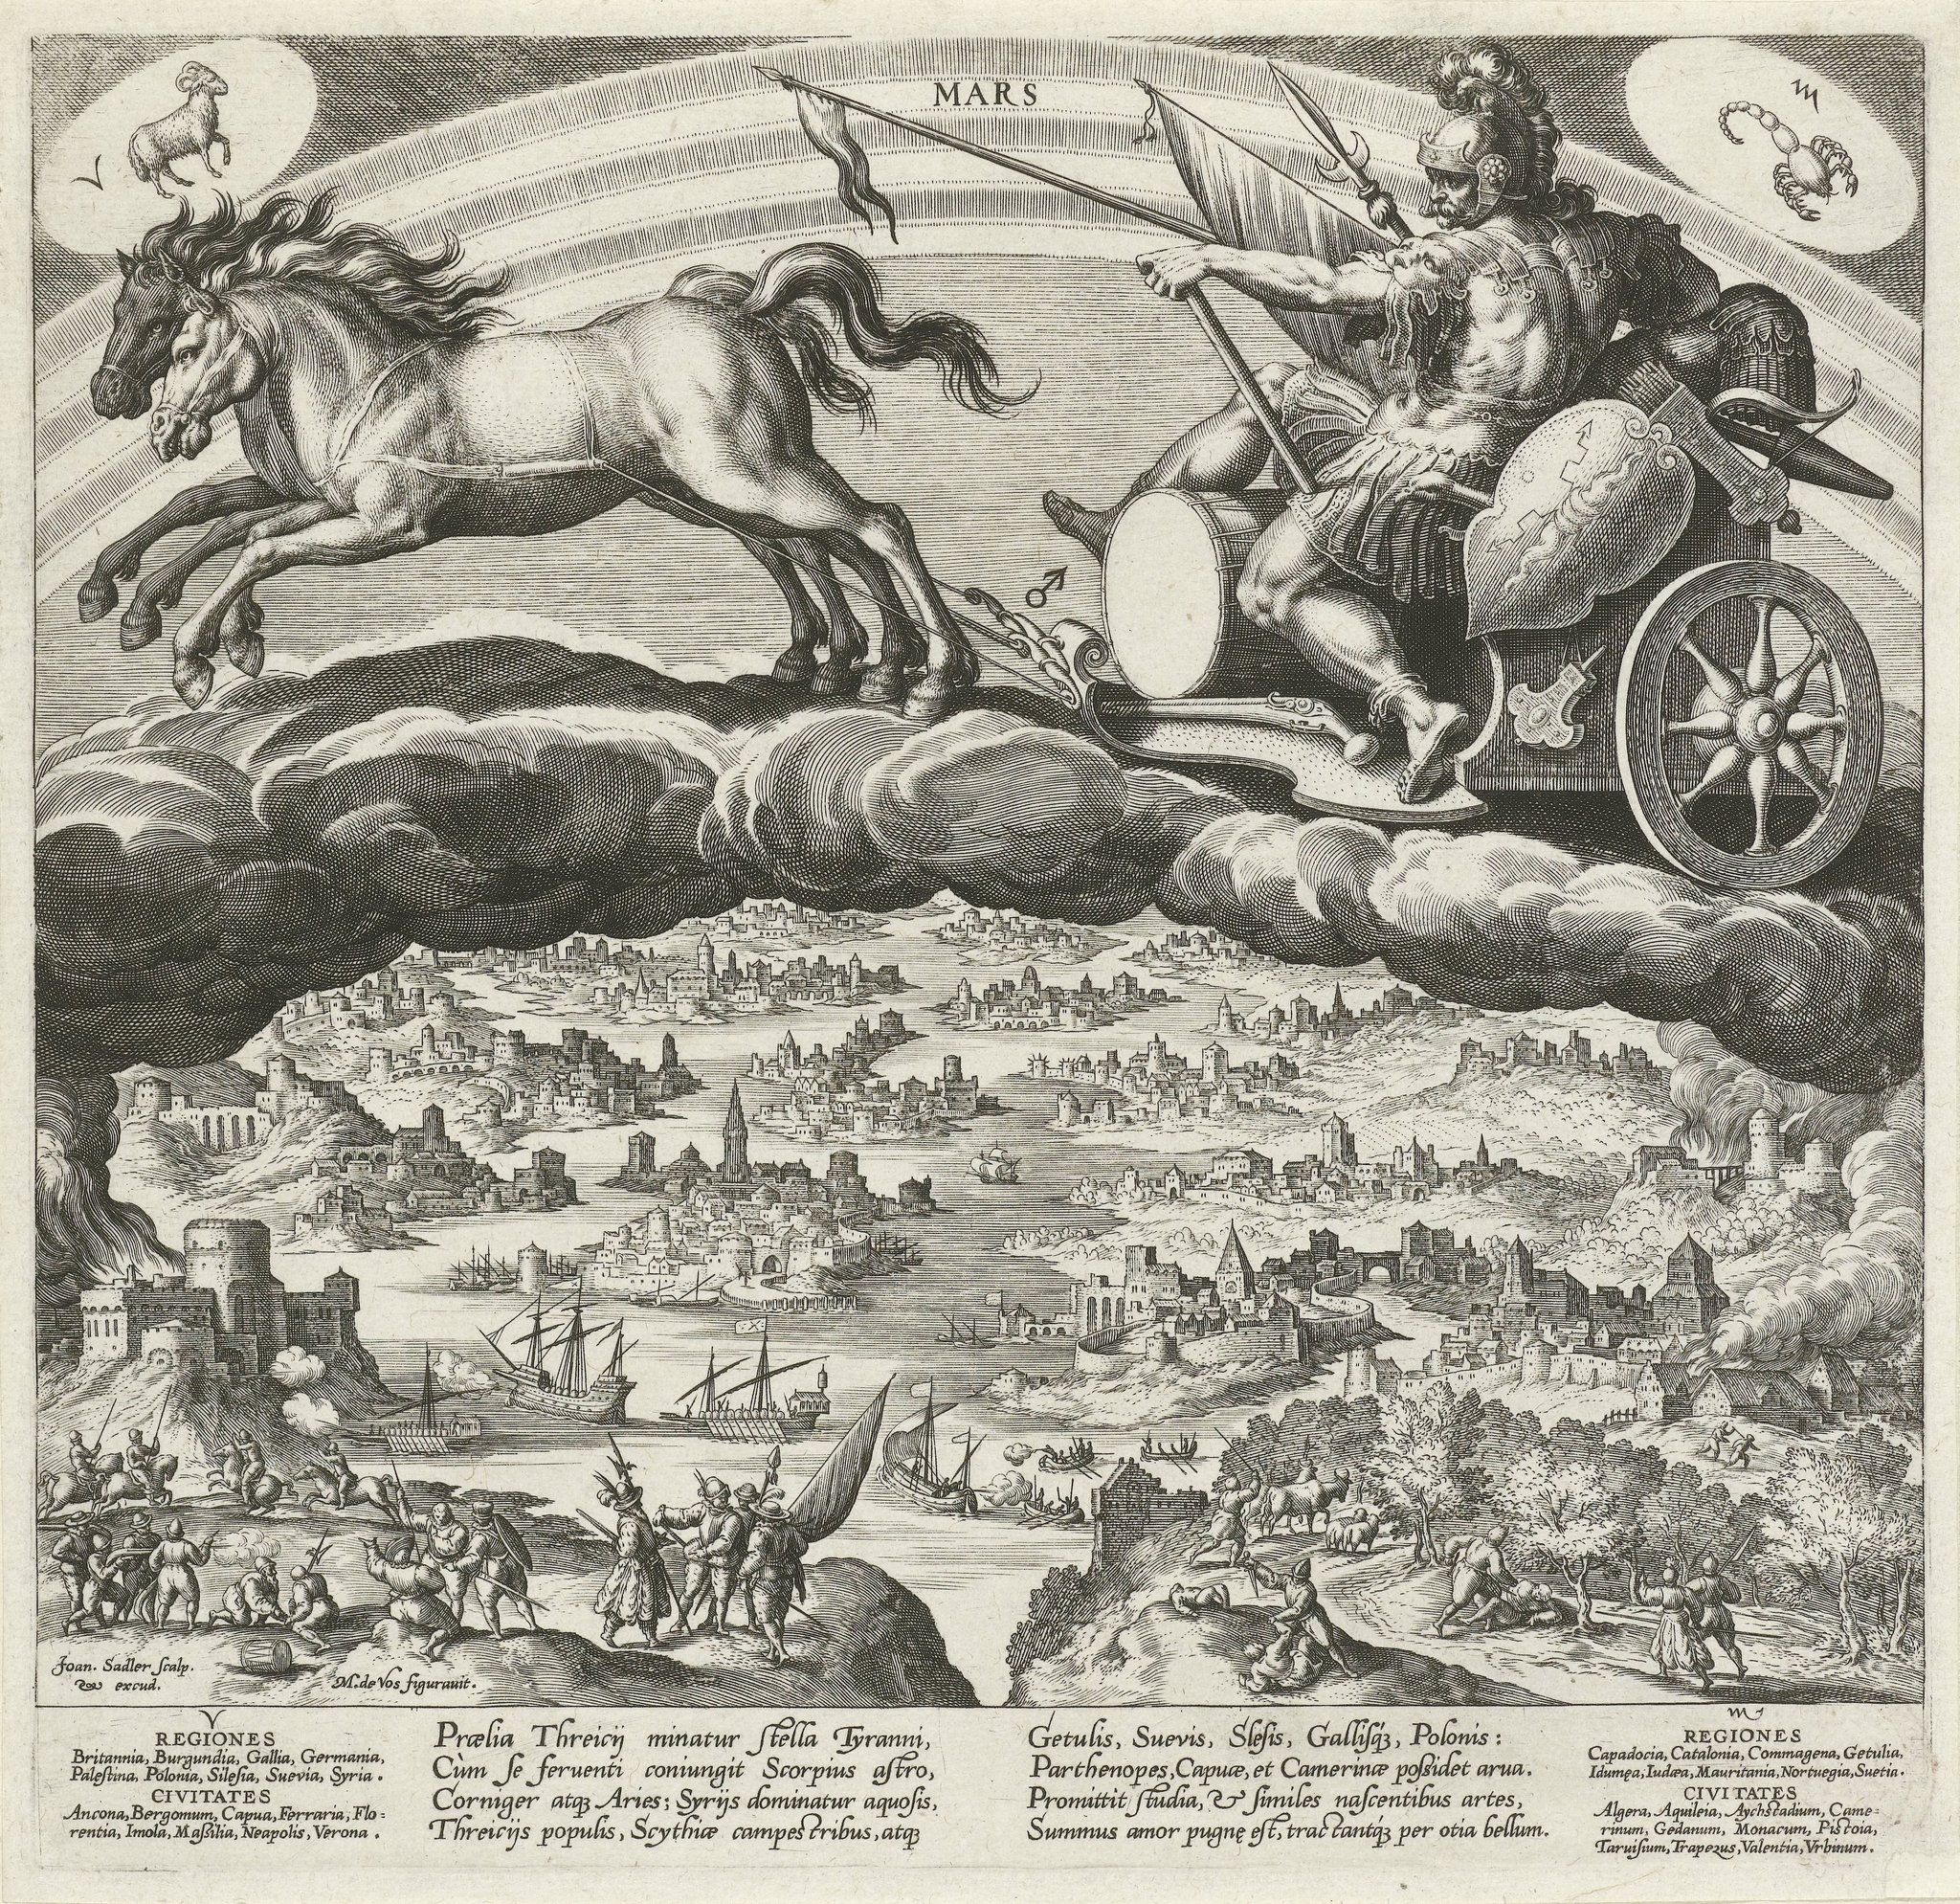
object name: print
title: De zeven planeten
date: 1585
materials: paper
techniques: engraving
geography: antwerp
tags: military service, (story of) mars (ares), siege, position war, mars and his children ('planetenkinder') ~ aries and scorpio, chariot, triumphal car, landscapes with waters, waterscapes, seascapes (in the temperate zone), fighting, italy, germany, spain, england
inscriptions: collector's mark: Lugt 240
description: De god Mars op zijn zegewagen, getrokken door twee paarden, rijdend op de wolken. Linksboven het sterrenbeeld Ram, rechtsboven het sterrenbeeld Kreeft. Onderaan een rivierlandschap met vechtende soldaten en brandende steden. In de marge een Latijns lofdicht op de invloed van de planeet Mars op de streken van Europa (Engeland, Italië, Duitsland, Spanje). De prent maakt deel uit van een zevendelige reeks met als onderwerp de invloed der planeten op de wereld.